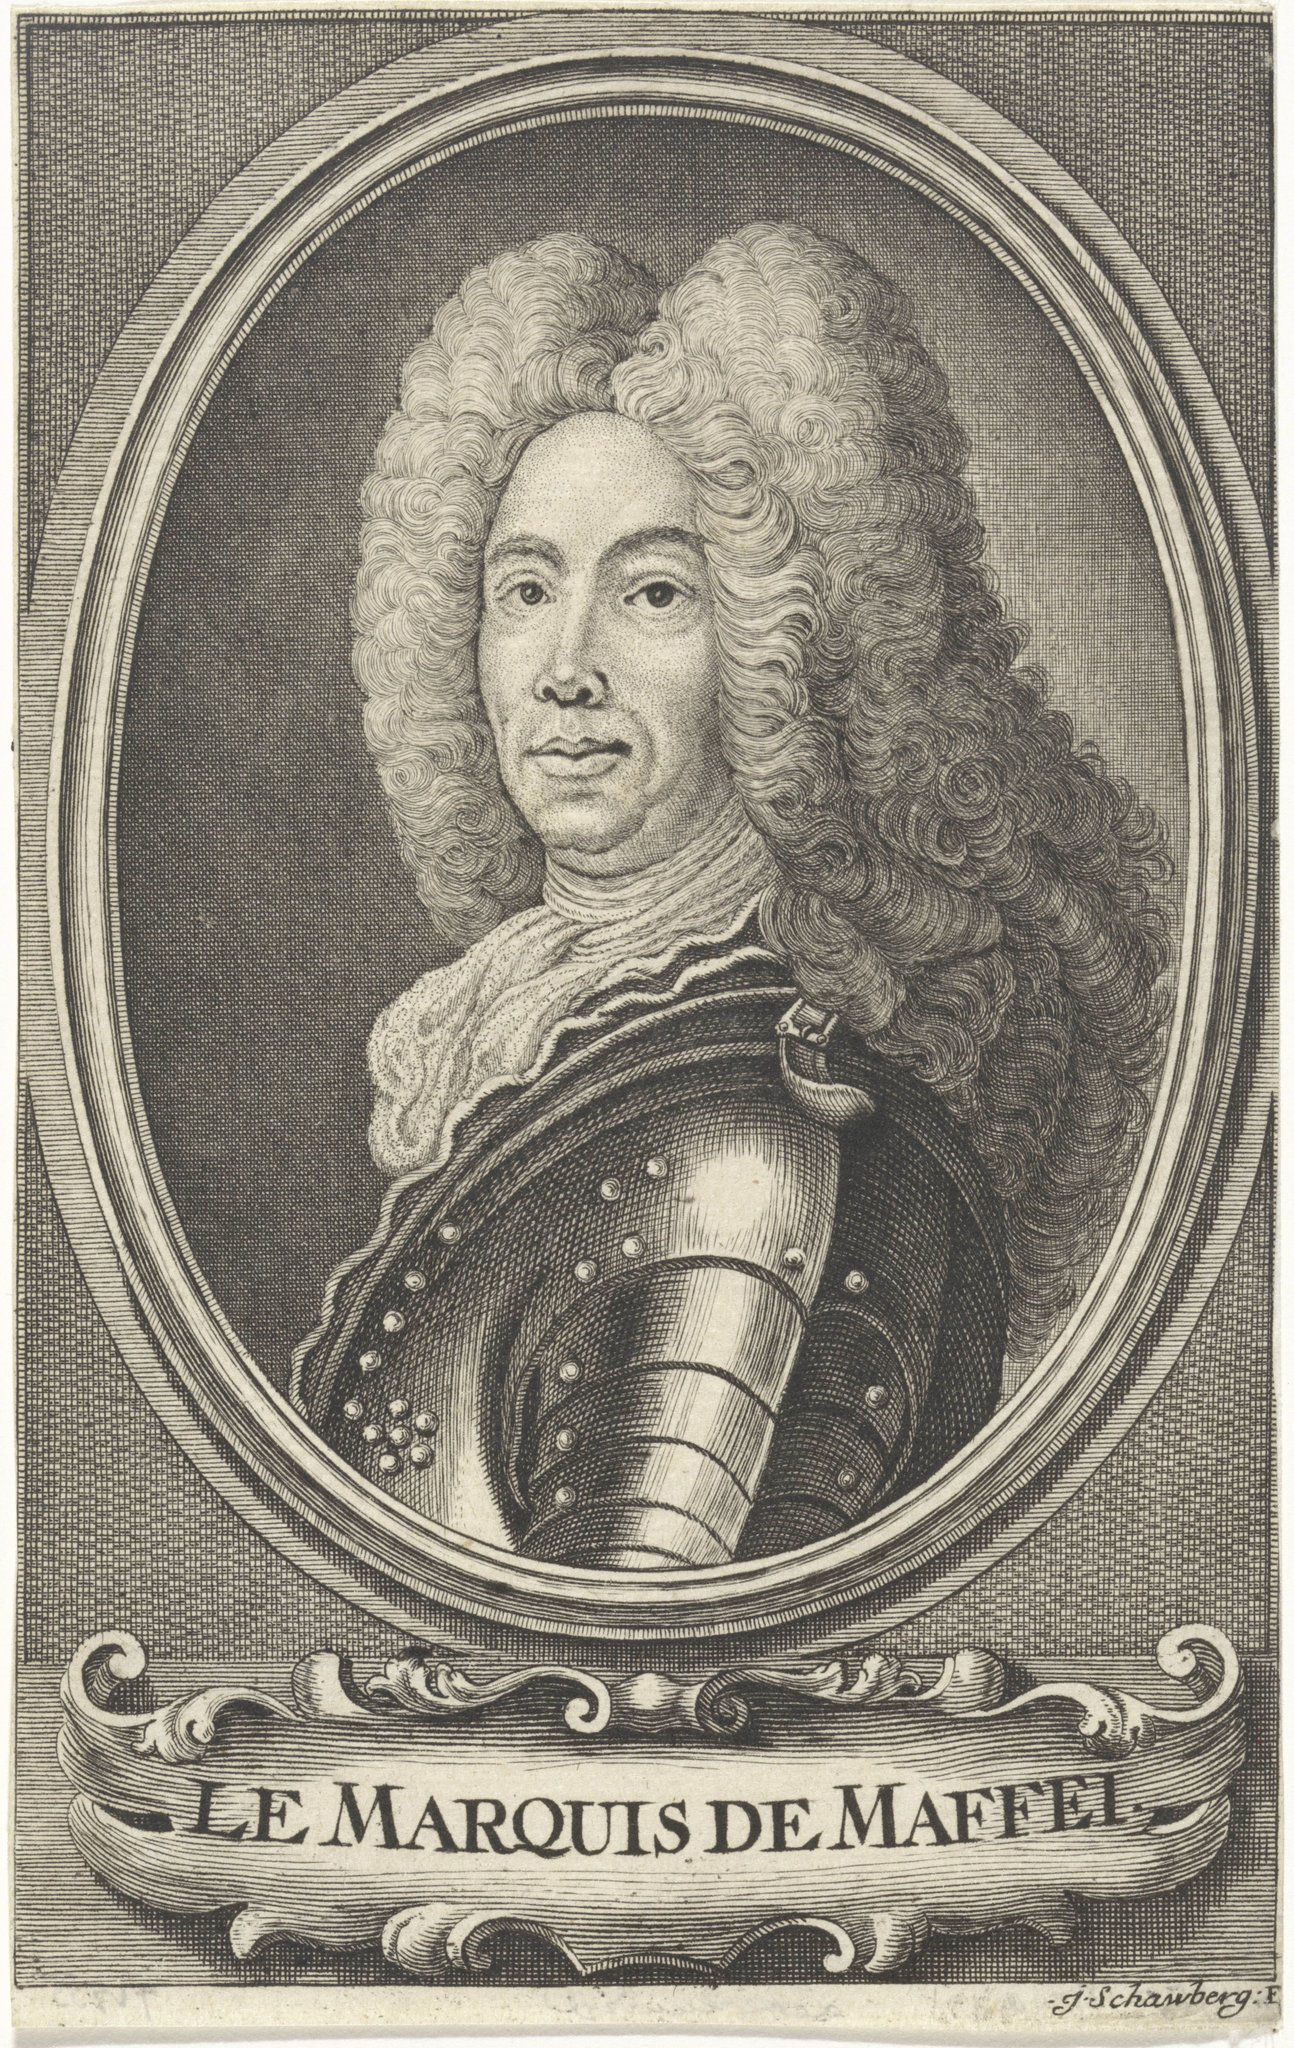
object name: print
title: Portret van de markies Alessandro Maffei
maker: jean henri van schawberg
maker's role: print maker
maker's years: 1717-1760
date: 1740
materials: paper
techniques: engraving, etching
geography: antwerp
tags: armour, historical persons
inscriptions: inscription: ‘*1675, te Verona. Letterkundige. +1755’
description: Prent is gebruikt als boekillustratie in: Maffei, Alessandro. Mémoires du marquis Maffei: lieutenant-général des troupes de l'Electeur de Baviere, & ensuite de celles de l'empereur, Den Haag: Jean Neaulme, 1740